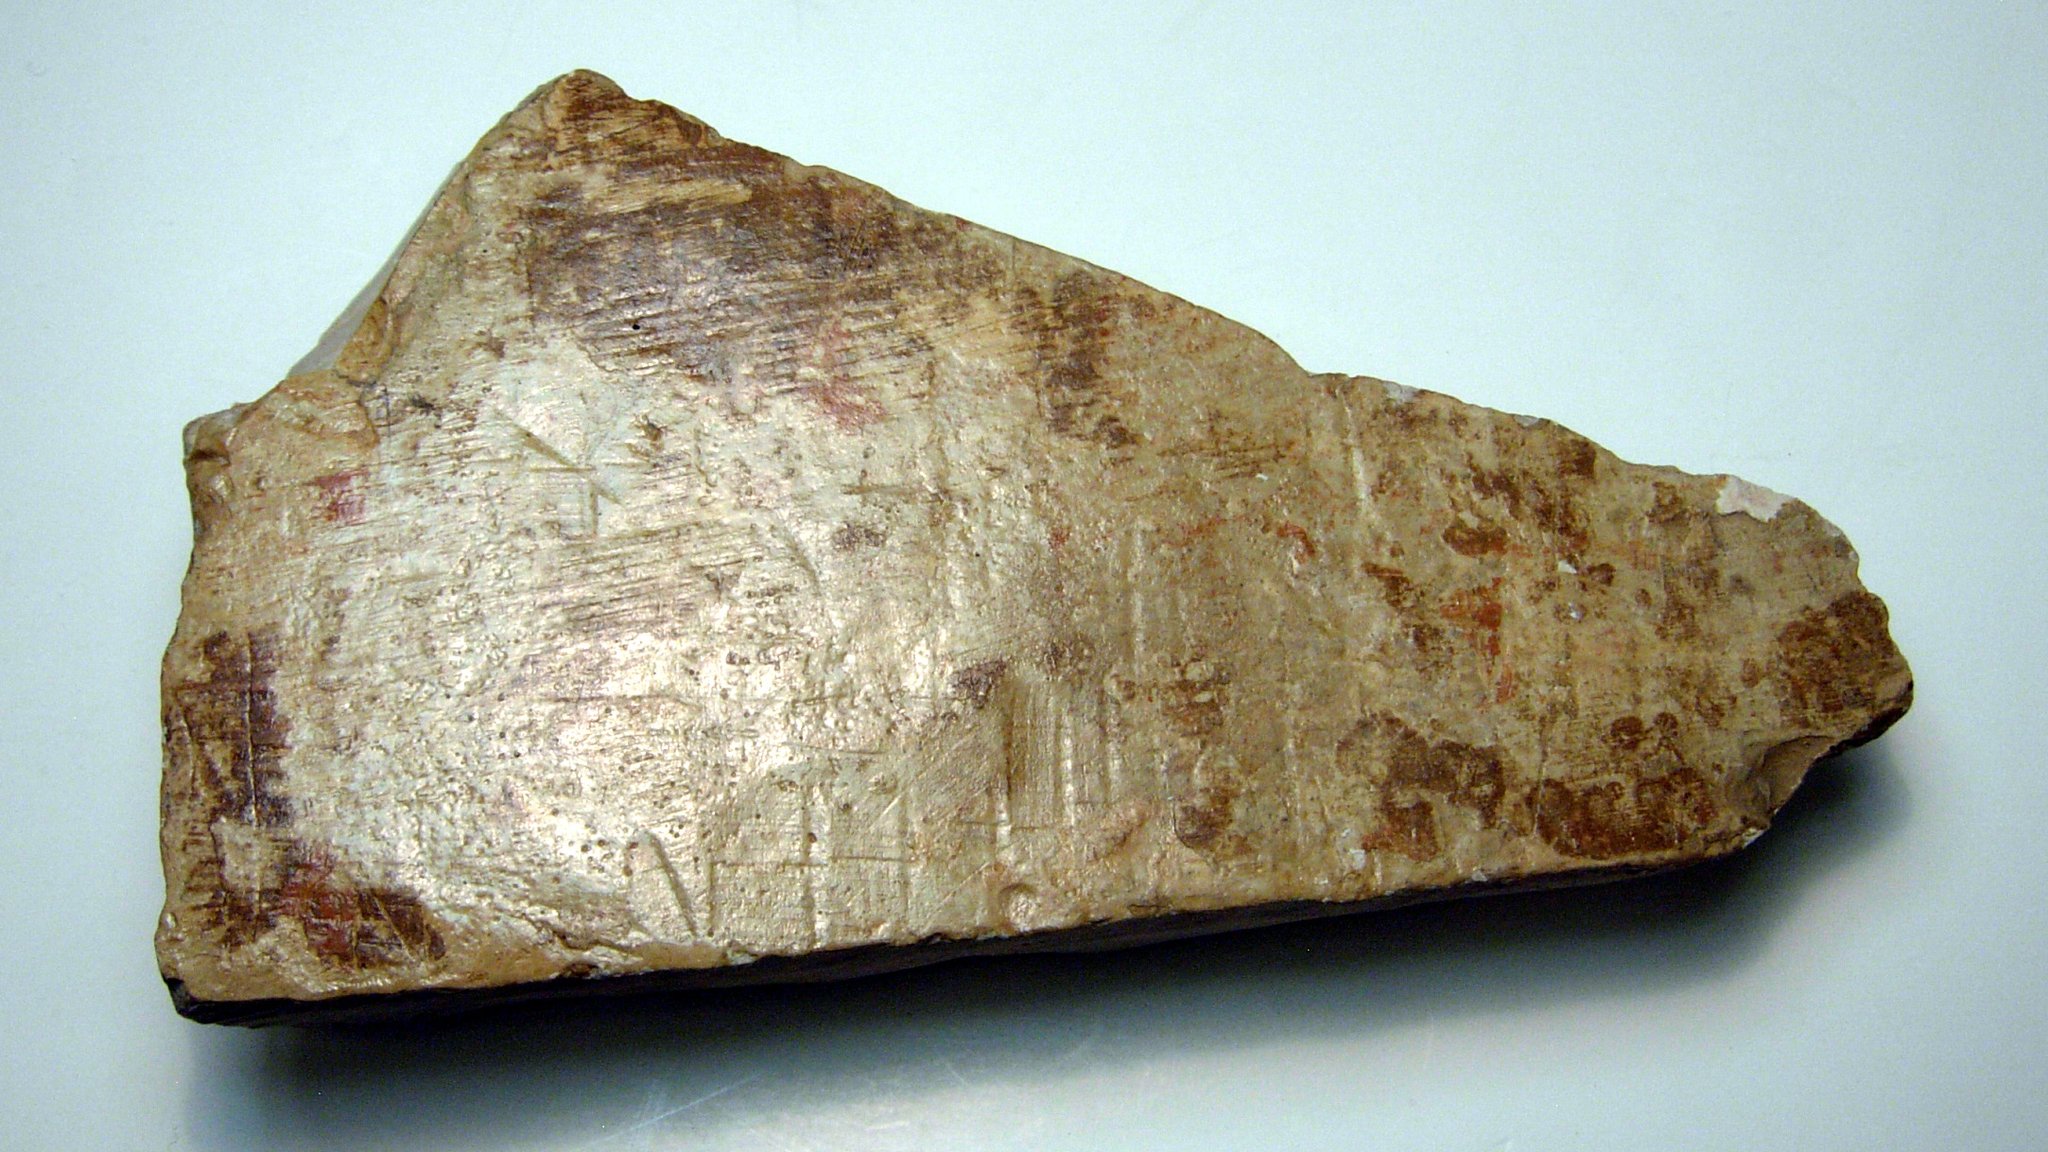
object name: relief, tomb of nespekashuty, wall casing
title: Wall casing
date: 664-610 BCE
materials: limestone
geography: egypt